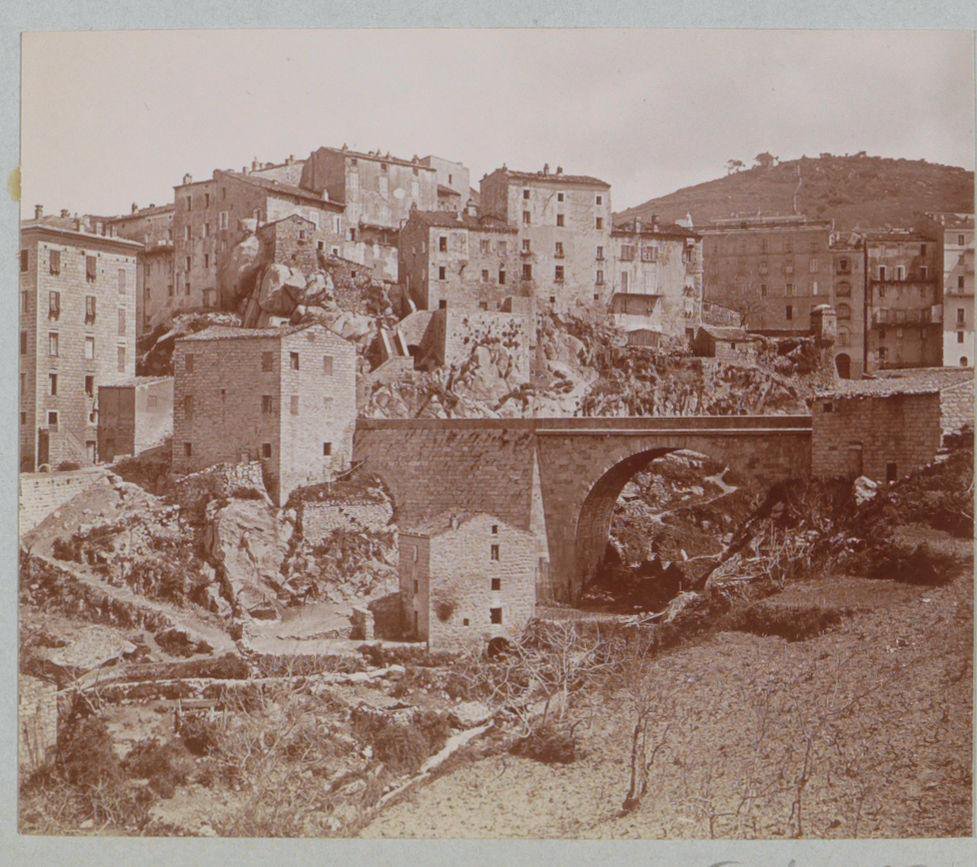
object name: photograph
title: Gezicht op een bergdorp, vermoedelijk op Corsica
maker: Anonymous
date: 1905-1910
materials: paper, photographic support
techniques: gelatin silver print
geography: corsica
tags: prospect of village, silhouette of village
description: Onderdeel van Fotoalbum van een Franse amateurfotograaf met bezienswaardigheden in Frankrijk, Zwitserland en Italië.